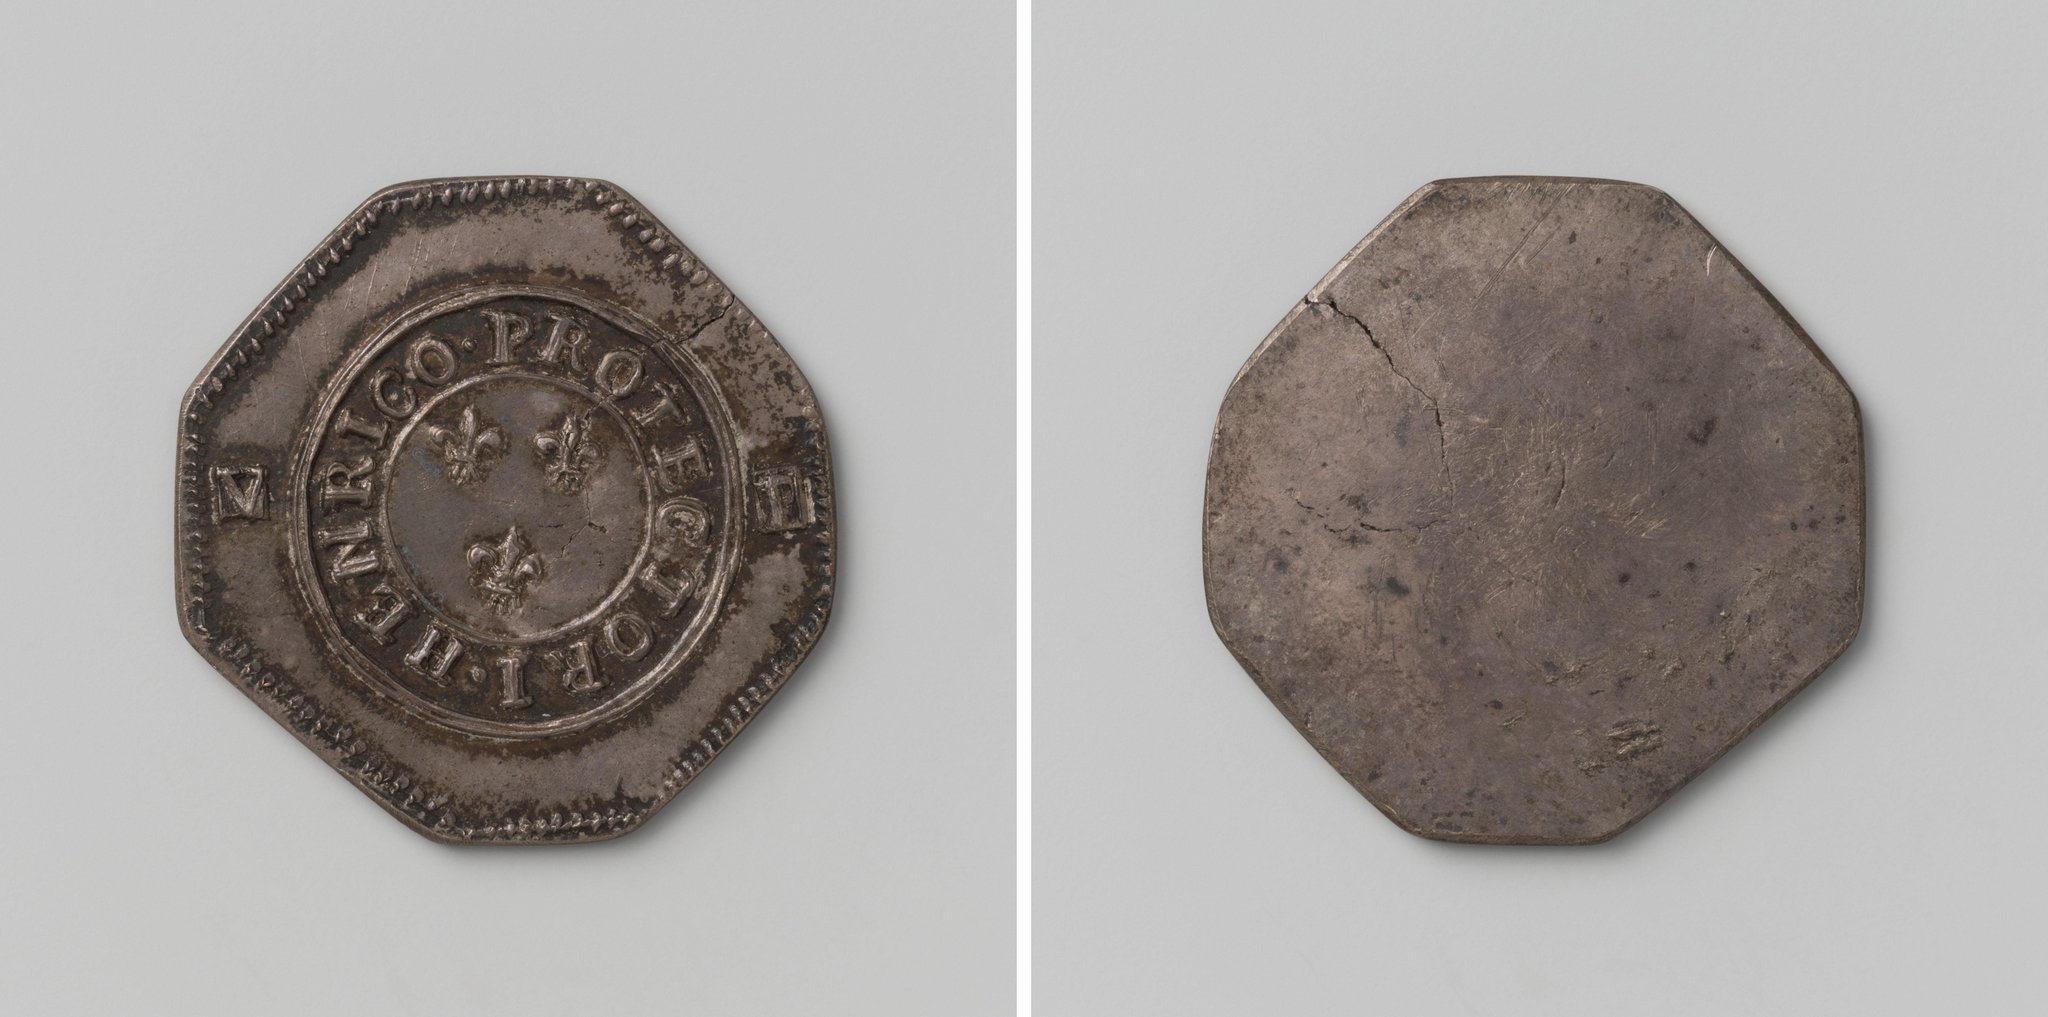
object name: siege coin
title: Vijf stuiver, vervalste noodmunt uit Kamerijk, geslagen tijdens het beleg door de Franse verdedigers van de stad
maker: Anonymous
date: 1589-1883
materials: silver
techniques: striking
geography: belgium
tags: paris, hendrik iv (koning van frankrijk en navarra)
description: eenzijdige, achthoekige noodmunt (vals) van Kamerijk. Voorzijde: binnen parelrand: drie stempels: in midden een grote, ronde stempel: drie lelies binnen omschrift; links en rechts: stempels met waardeaanduiding. Keerzijde: blanco